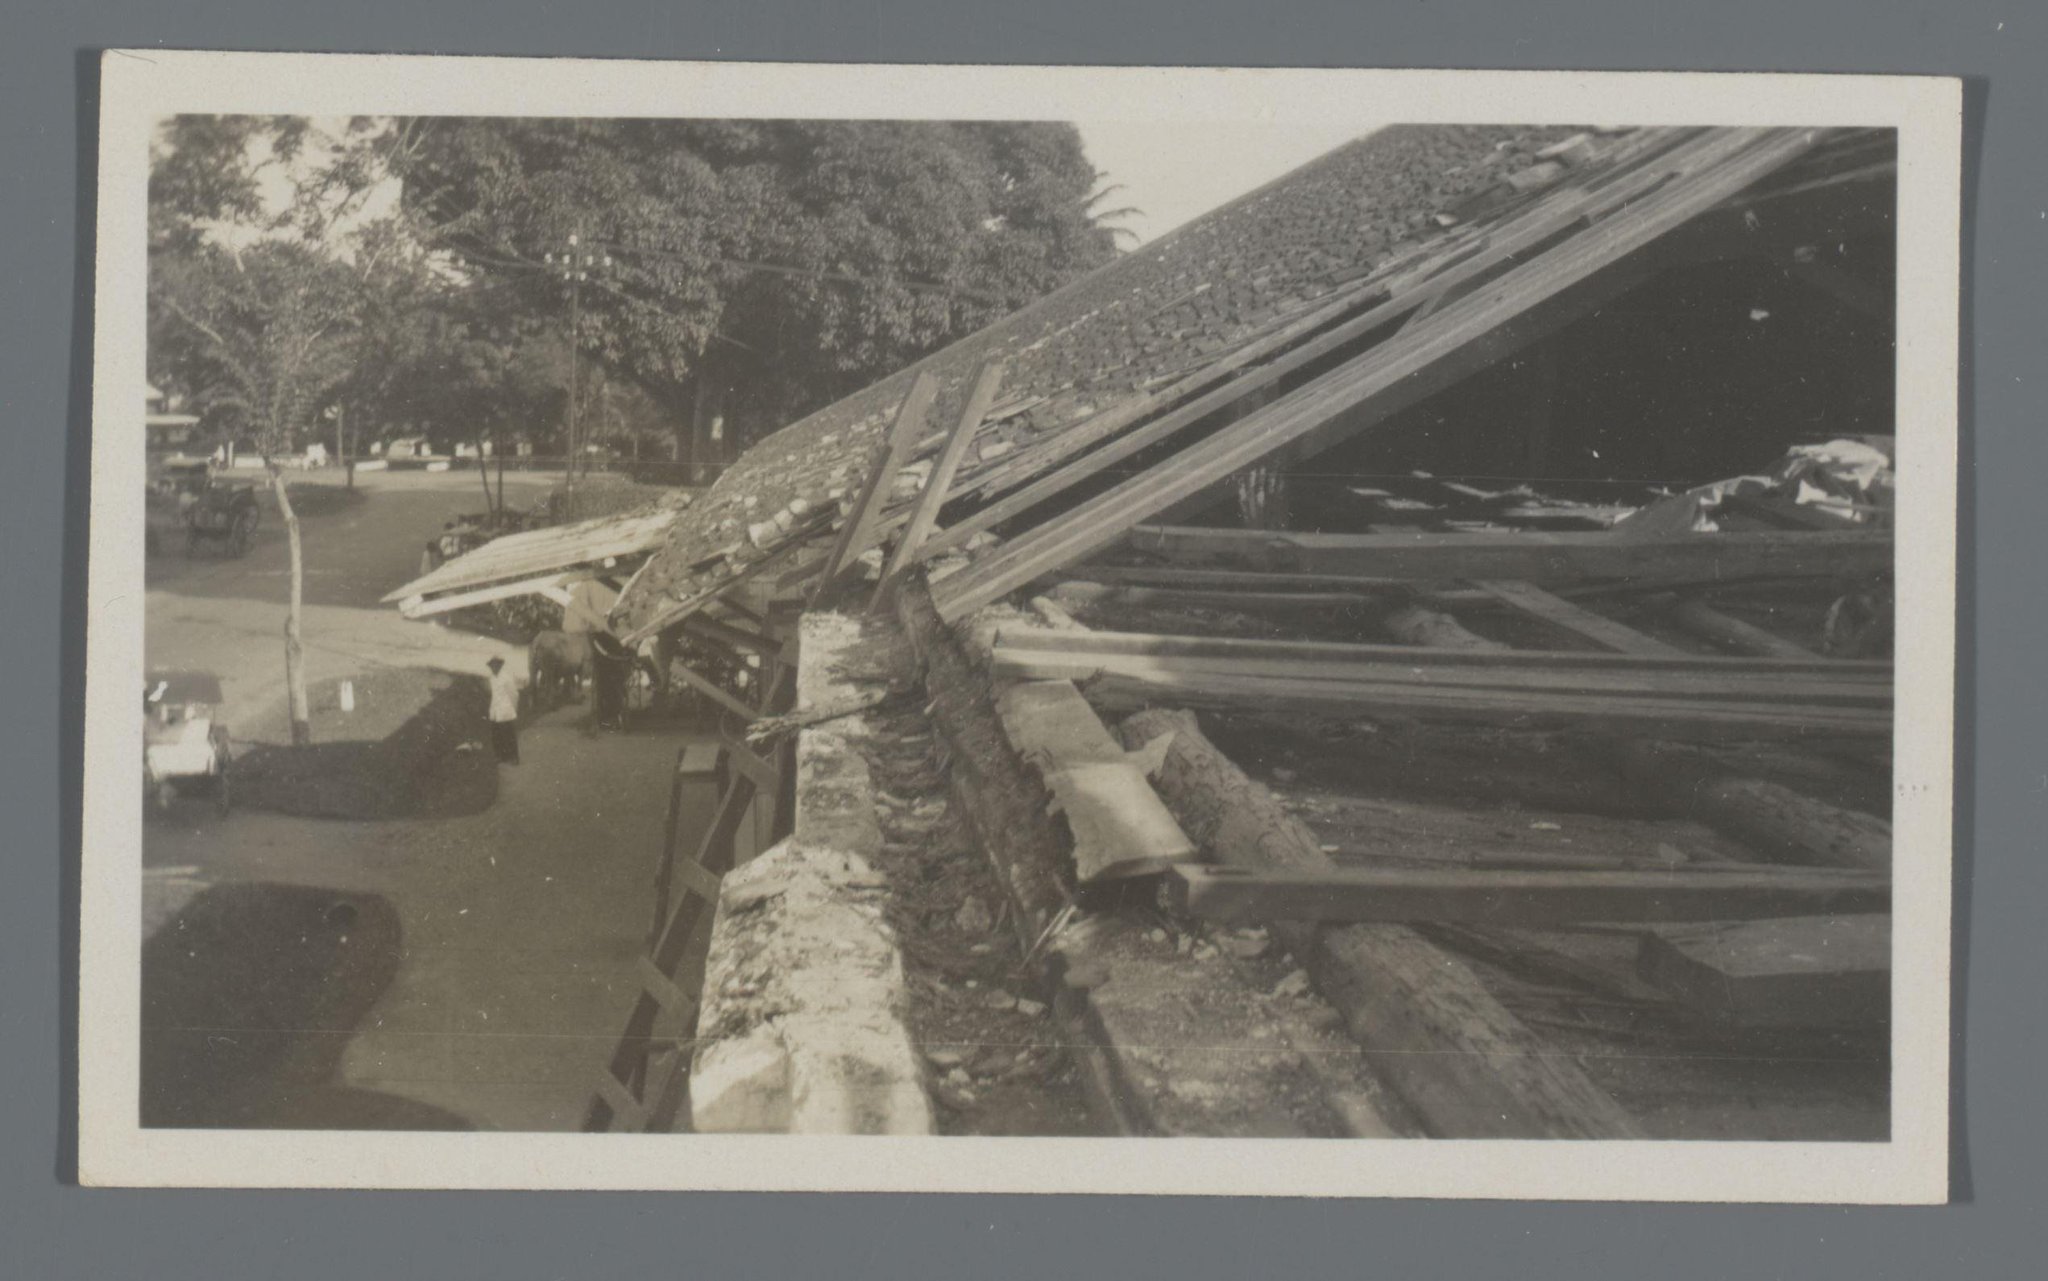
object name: photograph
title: Dakreparatie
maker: Anonymous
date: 1900-1940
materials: photographic support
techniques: collodion silver print, gelatin silver print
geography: sumatra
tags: sumatra, dutch east indies, the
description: Werkzaamheden bij het repareren van een dak. Onderdeel van een groep van 14 losse foto's genomen op Midden- en Zuid-Sumatra in de periode ca. 1900-1940.